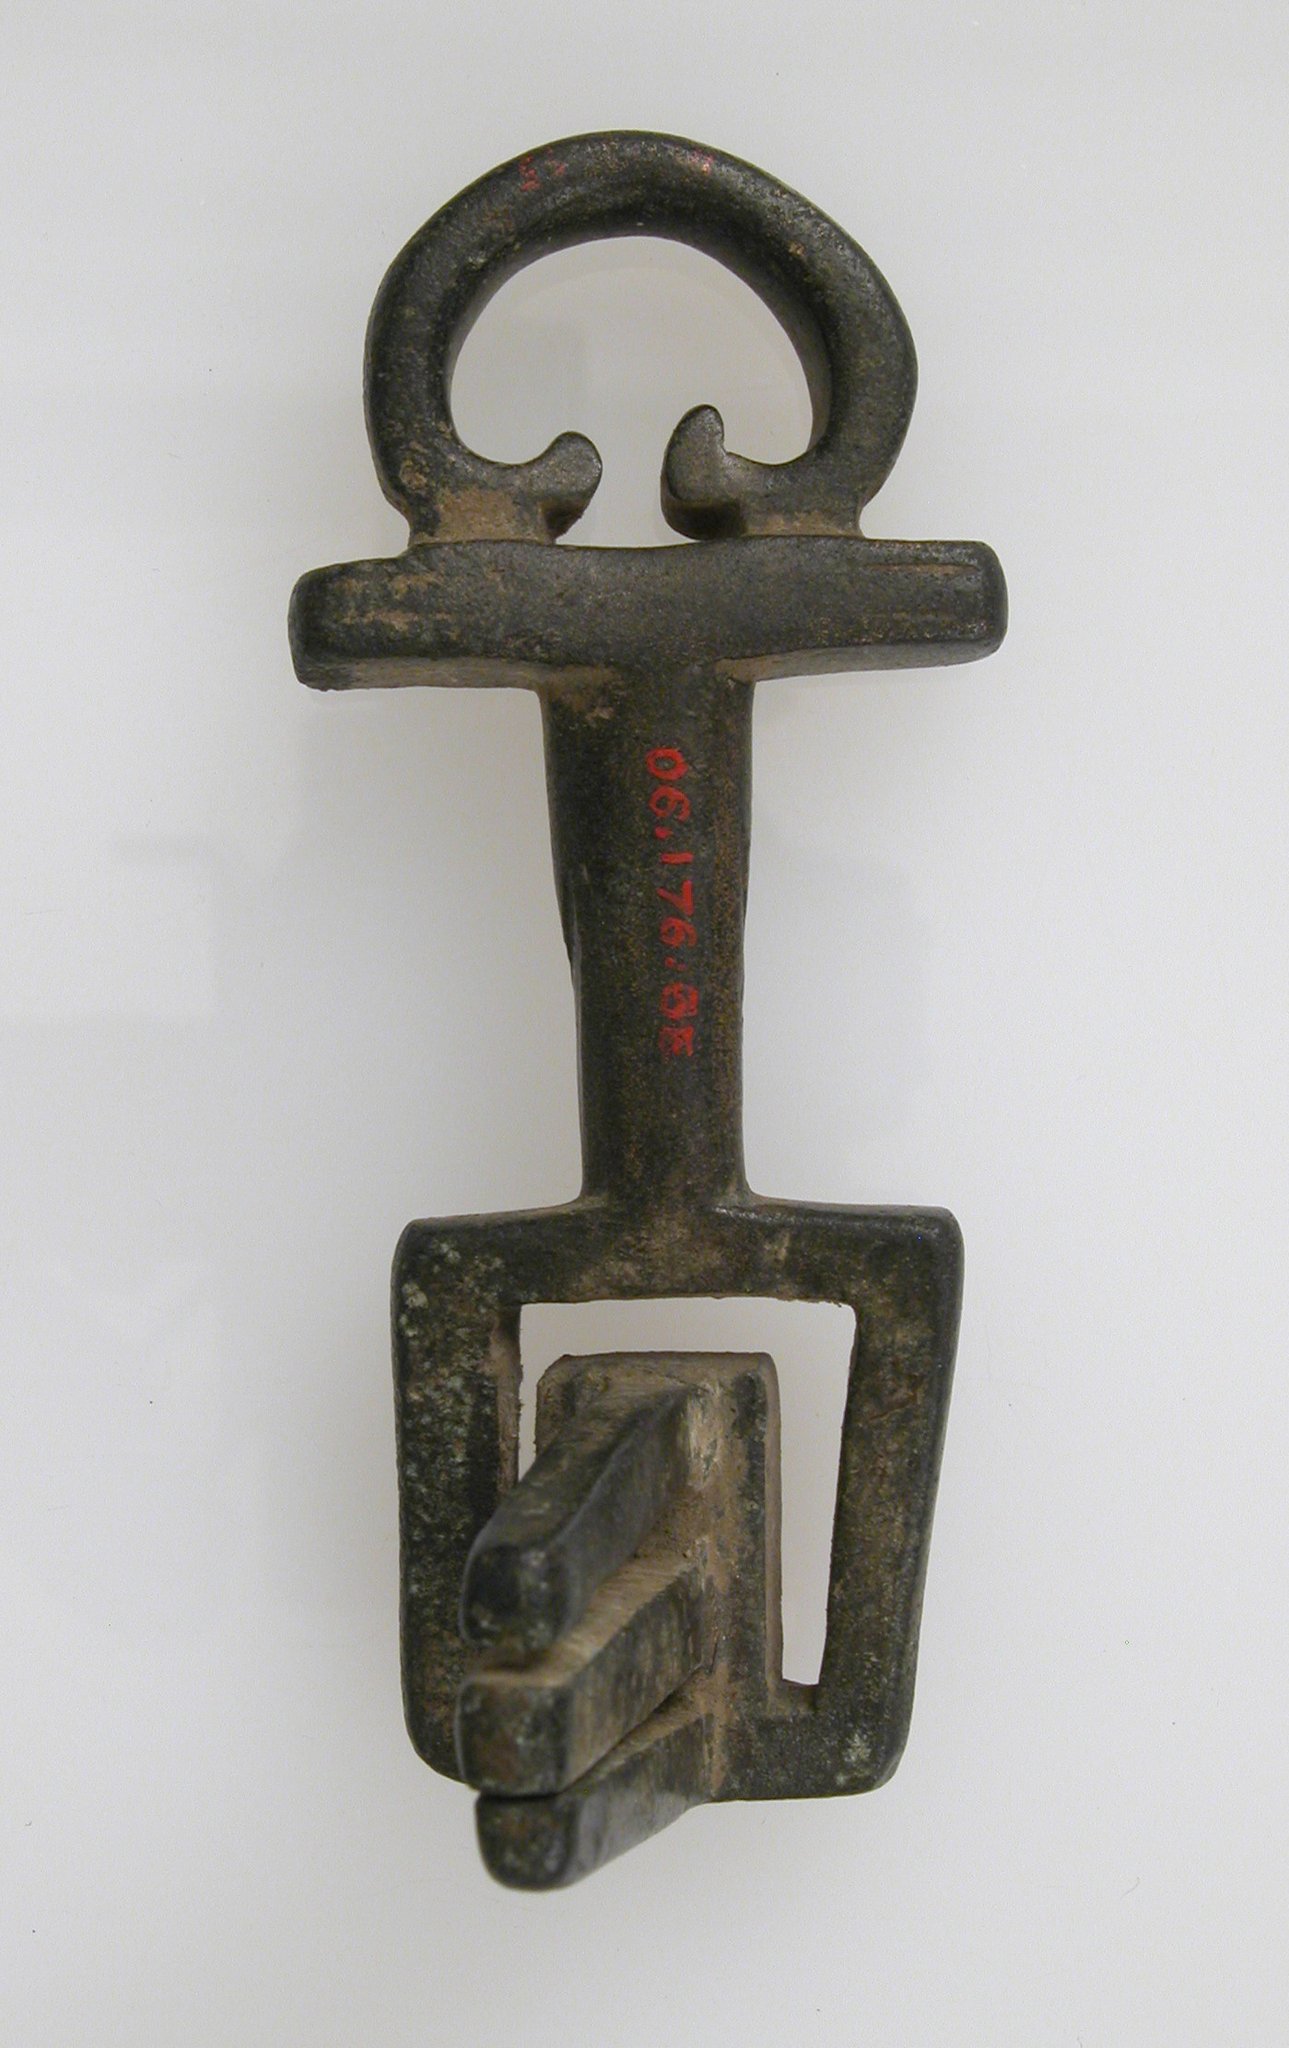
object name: key latch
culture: roman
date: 1-700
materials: copper alloy